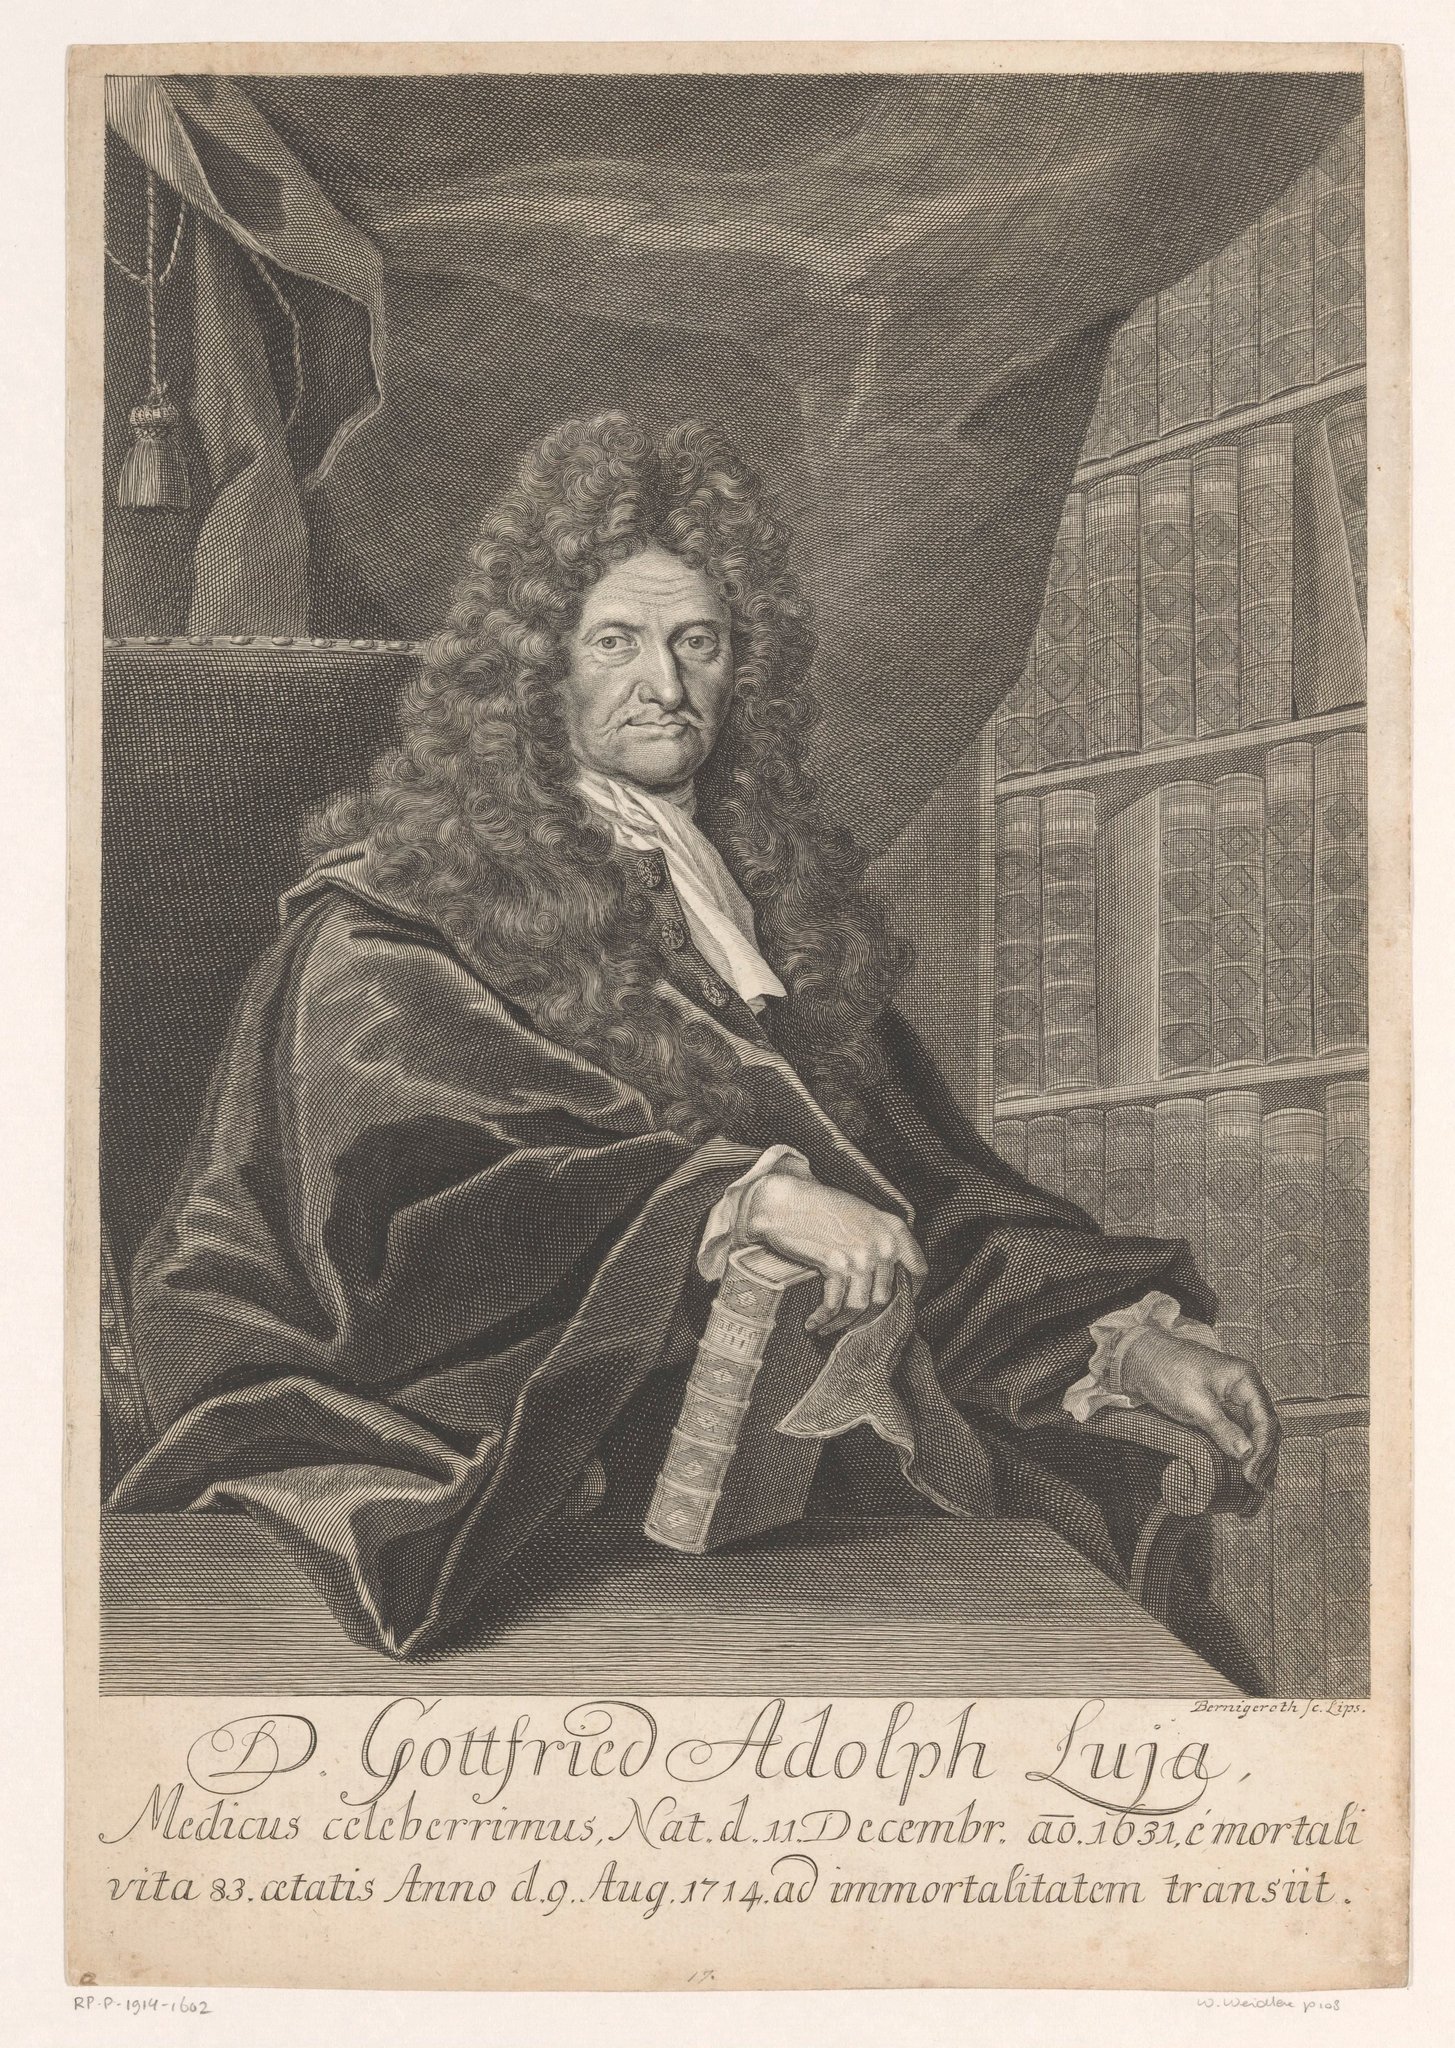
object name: print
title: Portret van Gottfried Adolpoh Luja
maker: martin bernigeroth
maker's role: print maker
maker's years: 1670-1733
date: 1714-1733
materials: paper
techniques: engraving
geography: leipzig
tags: bookshelves, historical persons, book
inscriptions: collector's mark: Lugt 2228